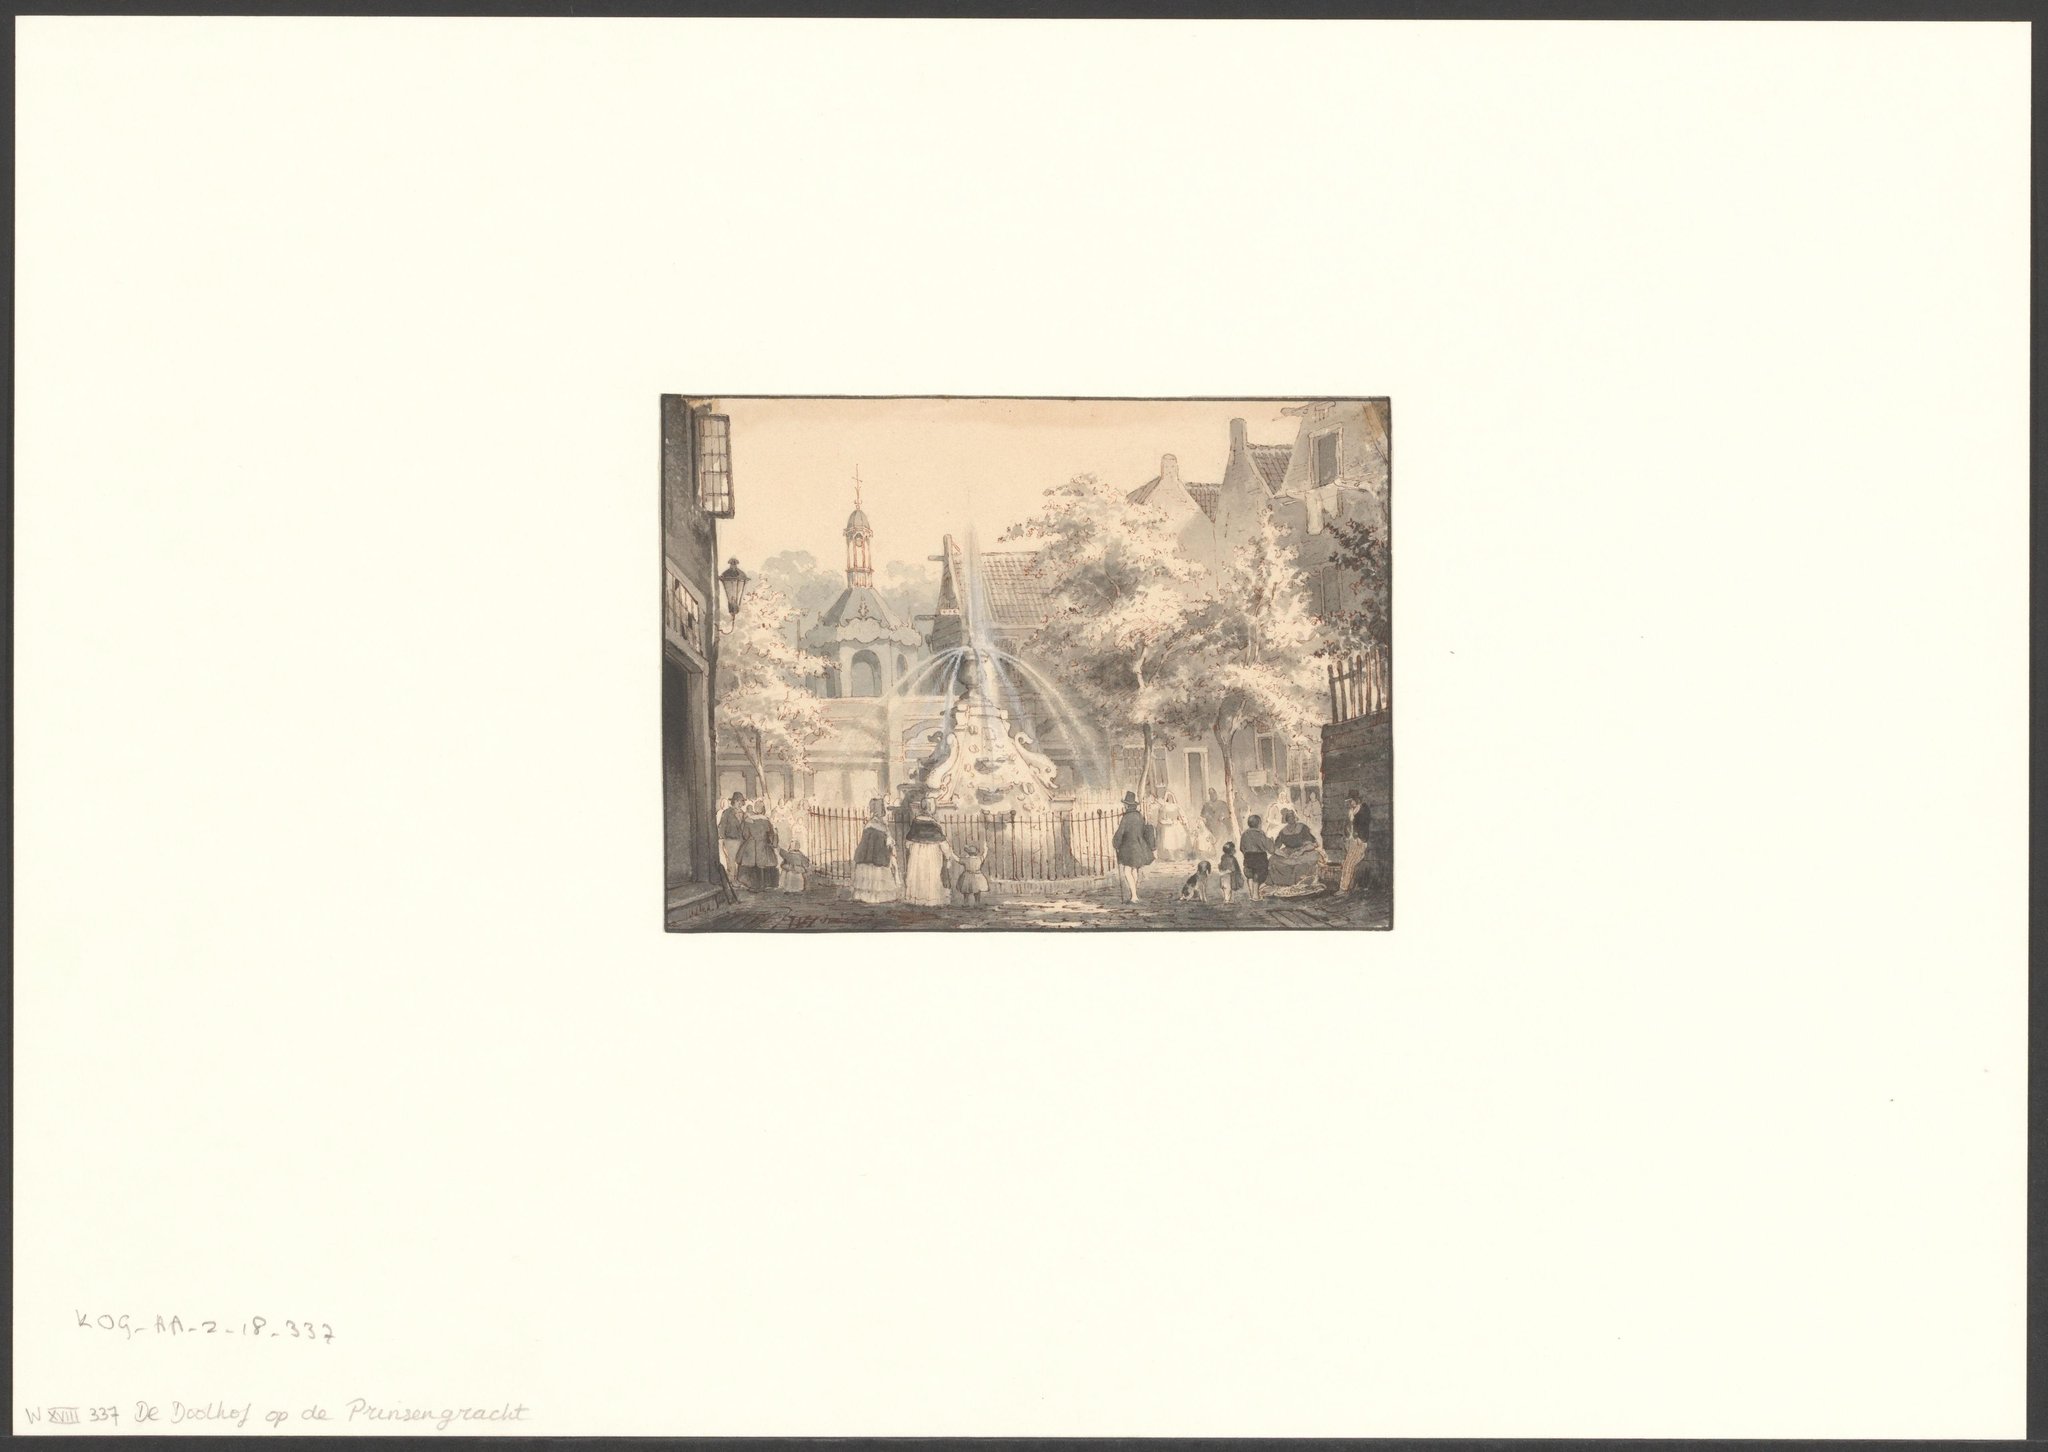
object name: drawing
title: Gezicht op het Oude Doolhof aan de Prinsengracht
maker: willem hekking jr.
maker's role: print maker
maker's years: 1825-1904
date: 1835-1904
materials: paint, ink, paper, pencil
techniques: brush, pen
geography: amsterdam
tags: city-view in general; 'veduta', garden fountain, labyrinth, maze ~ garden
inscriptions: signature: ‘WHjunior’, collector's mark: Lugt 800a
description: Tekening binnen de Atlas Van Eck ingedeeld op wijknummer 18.